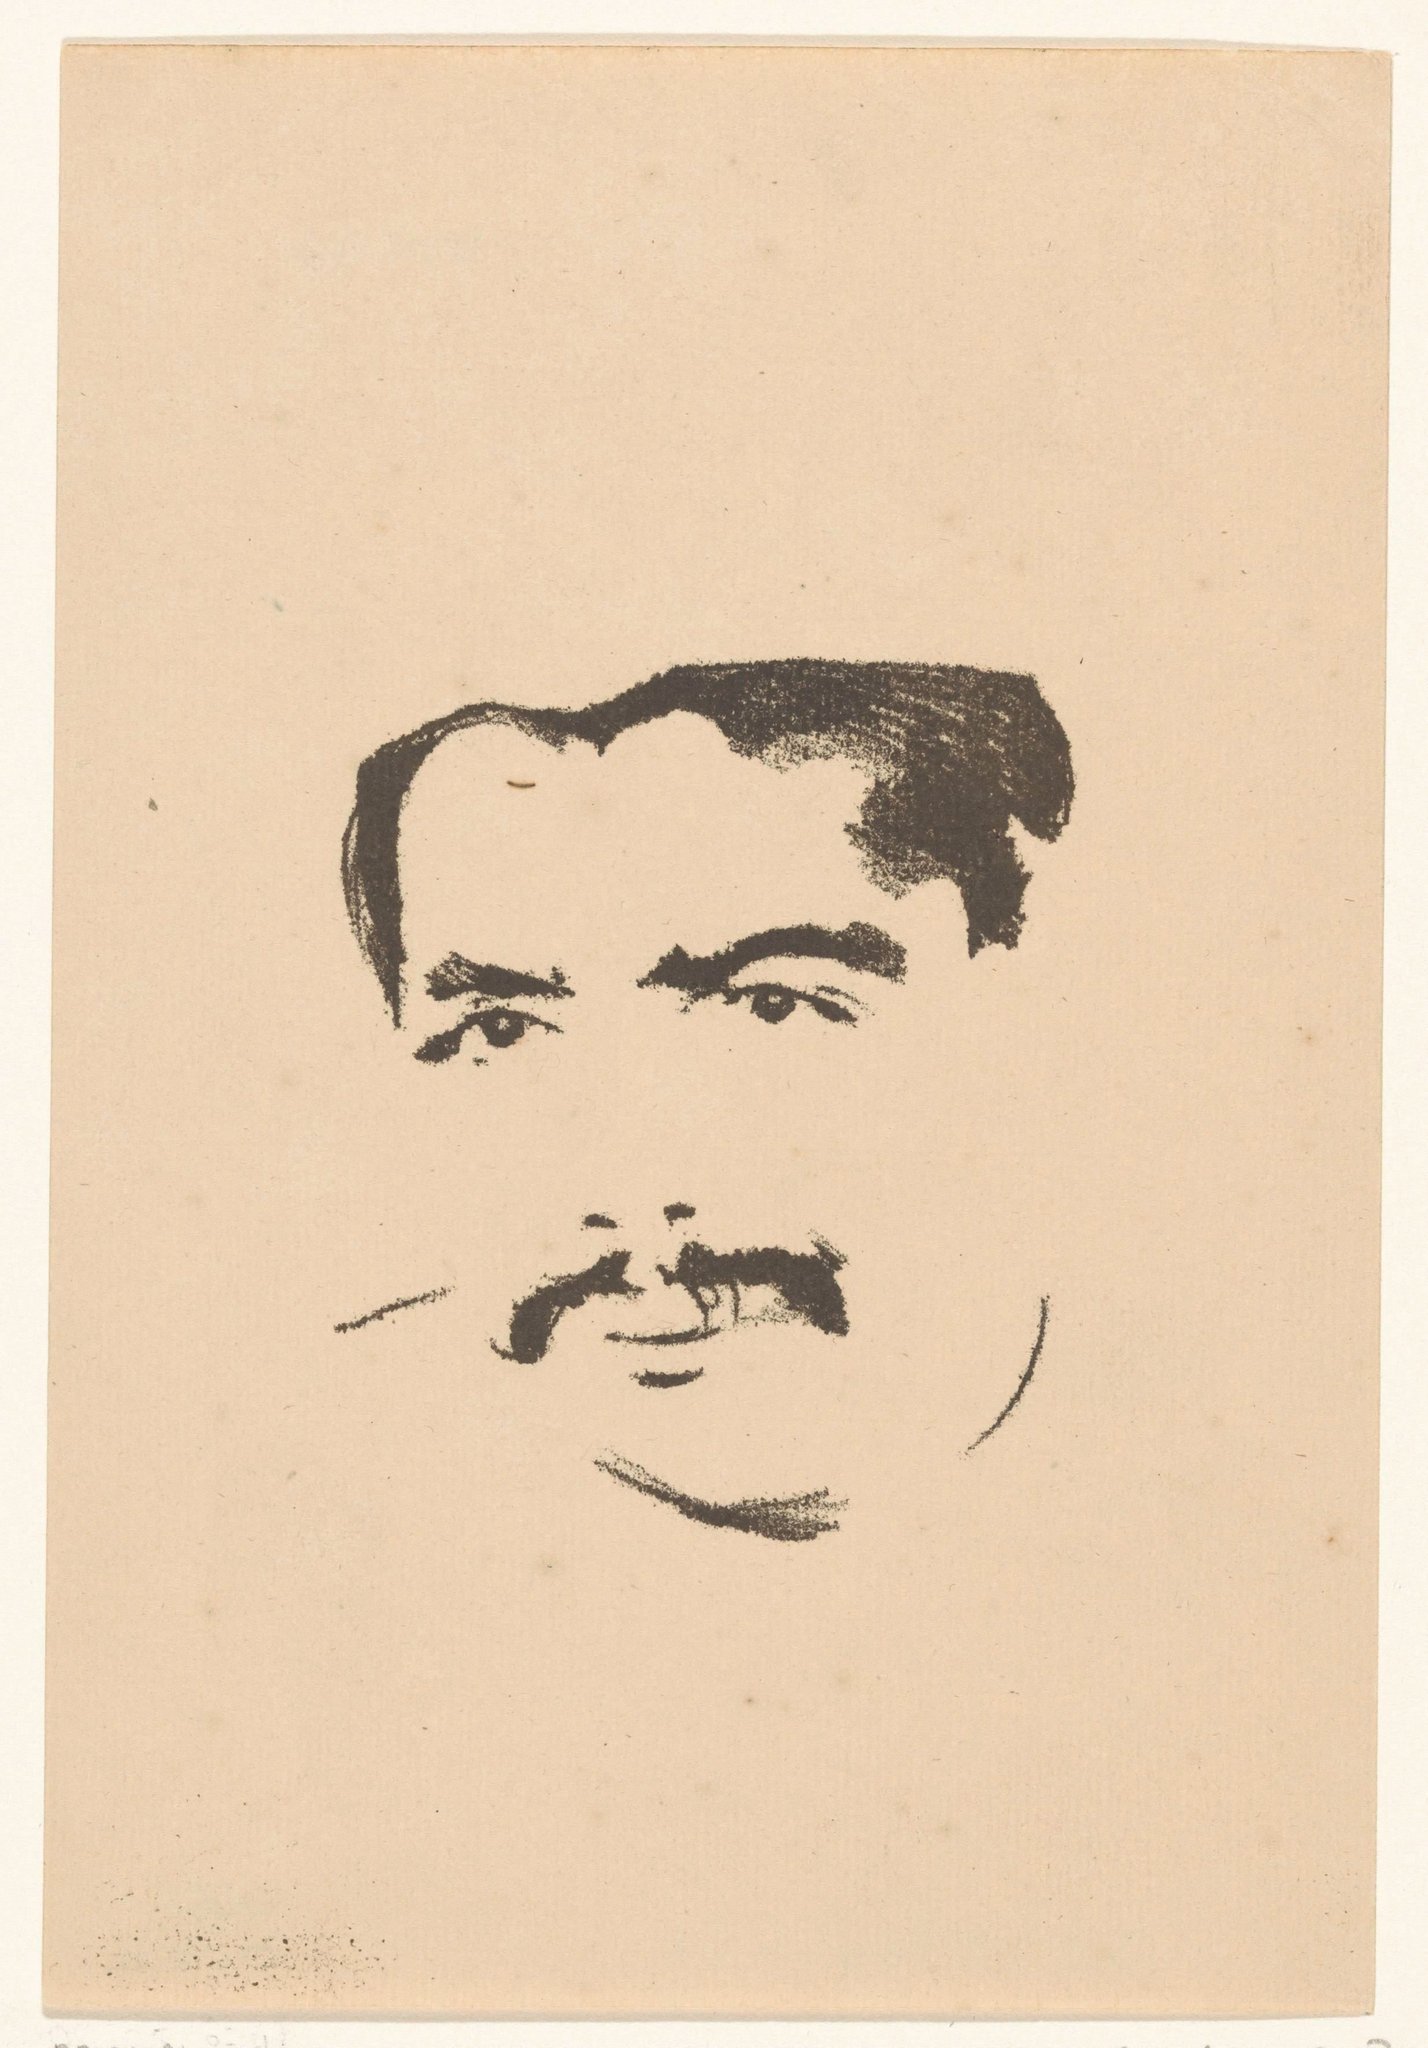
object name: print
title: Portret van Amit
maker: willem witsen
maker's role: draughtsman, painter, print maker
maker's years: 1860-1923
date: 1921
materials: paper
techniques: soft ground etching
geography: amsterdam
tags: historical persons (portraits and scenes from the life)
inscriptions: watermark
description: Alleen de haren, wenkbrauwen, ogen, snor, mond en kin afgebeeld. Amit was een kamerjongen in Hotel Bellevue, waar Willem Witsen verbleef toen hij in Buitenzorg was.